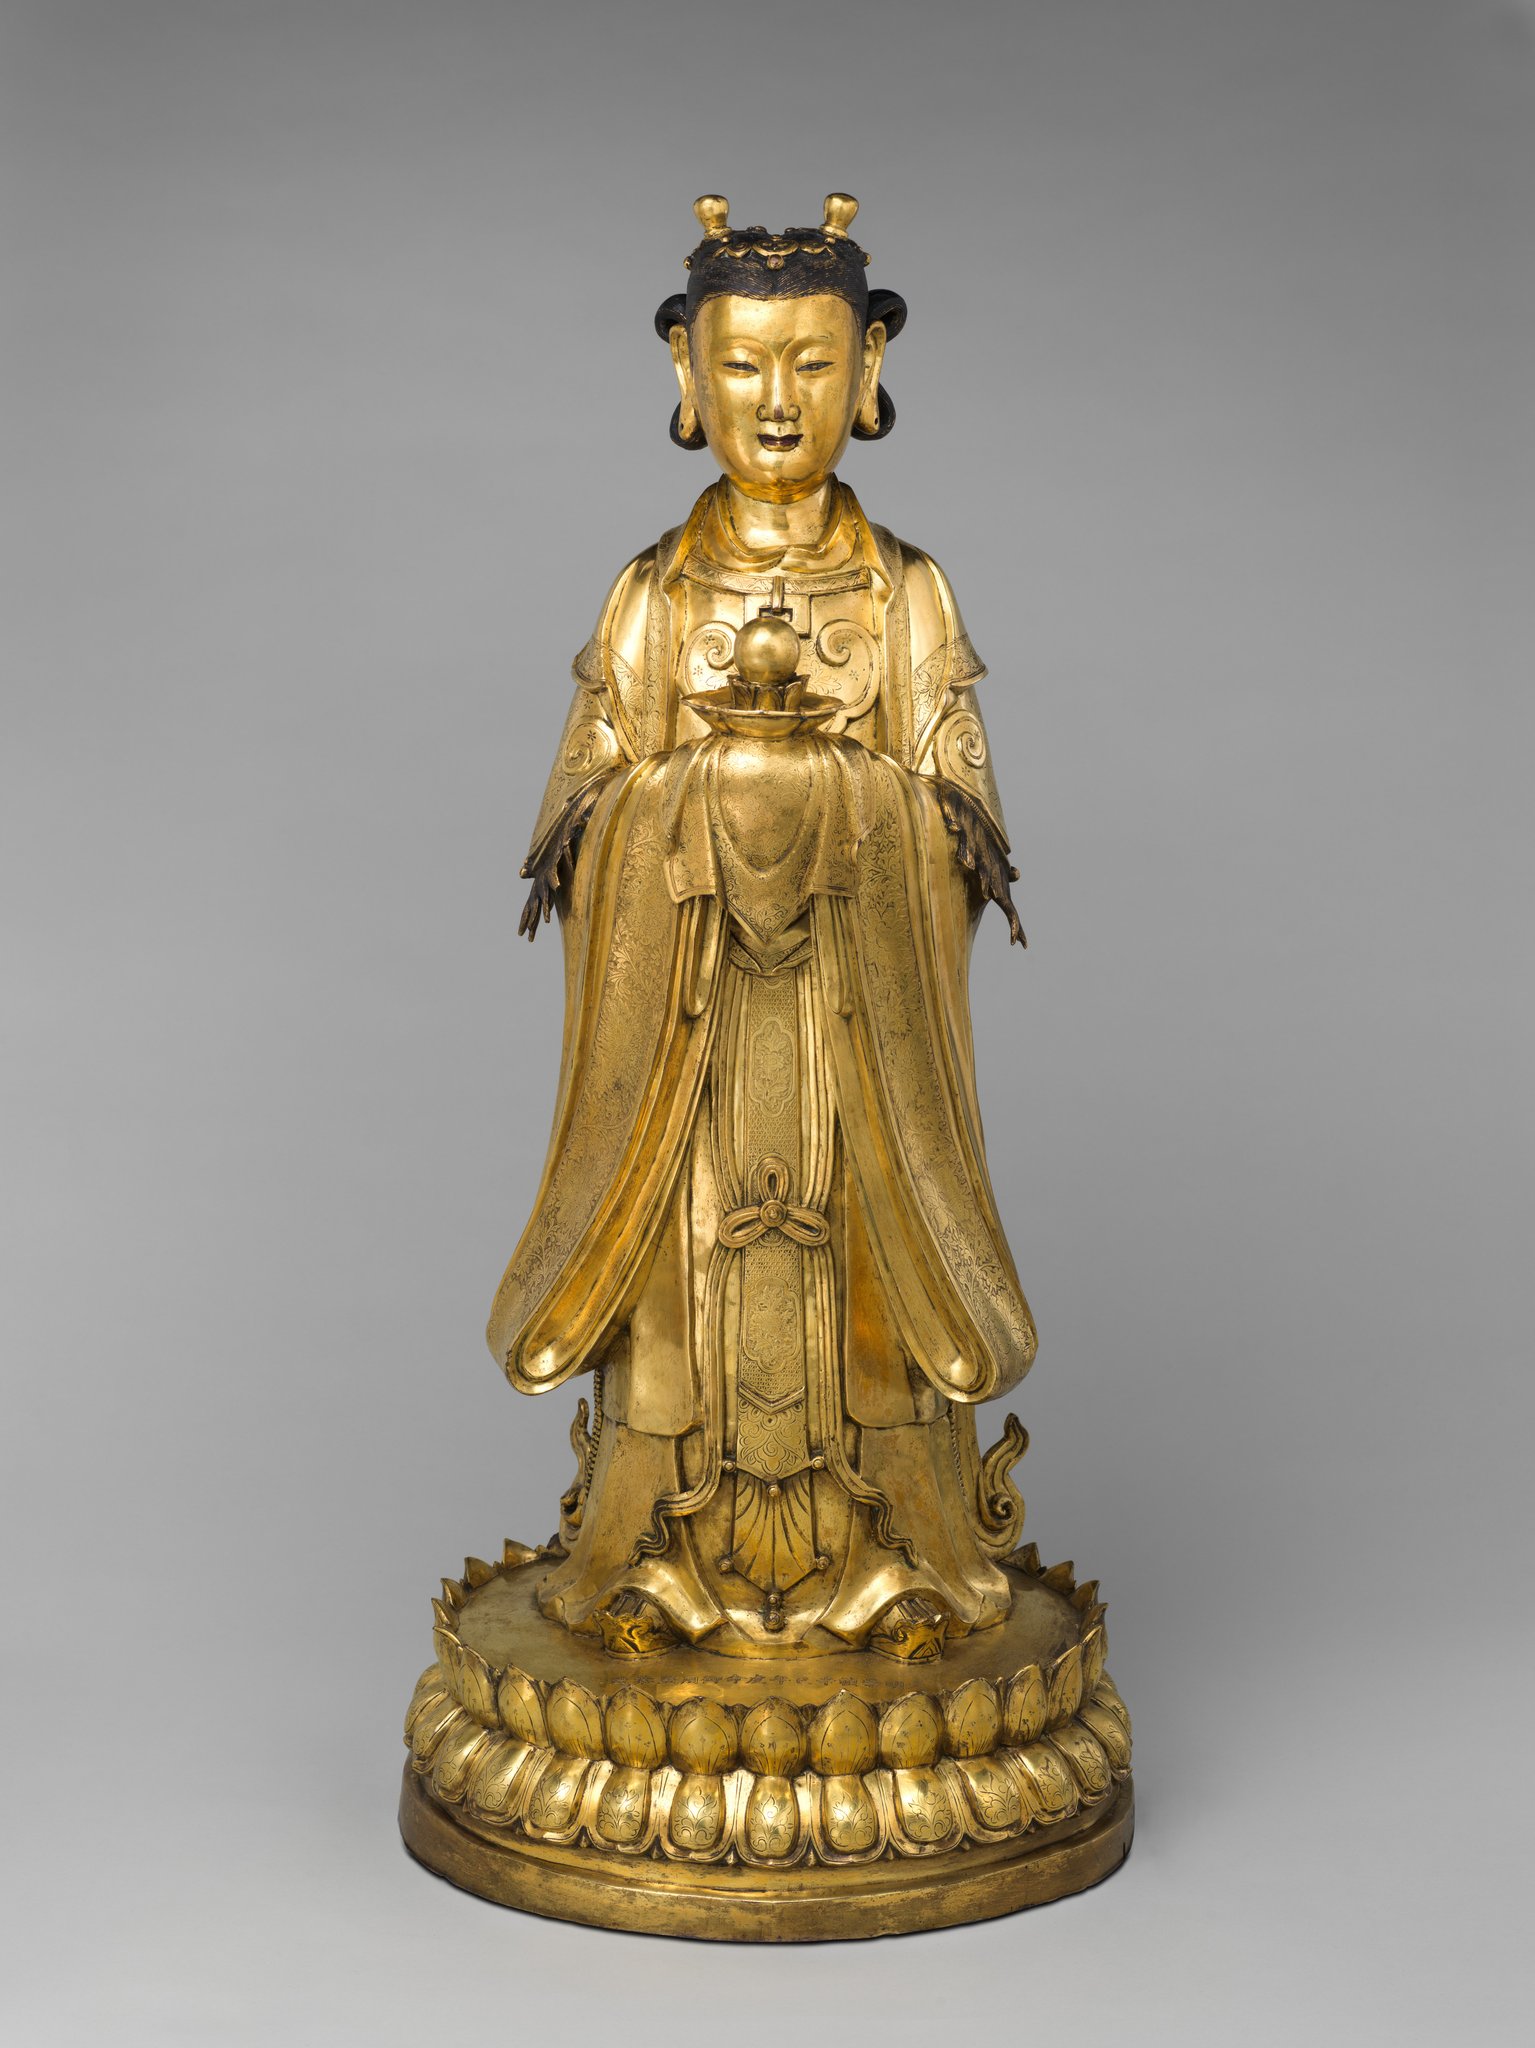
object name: figure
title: Dragon Girl (Longnü)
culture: chinese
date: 1641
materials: copper alloy, gilt